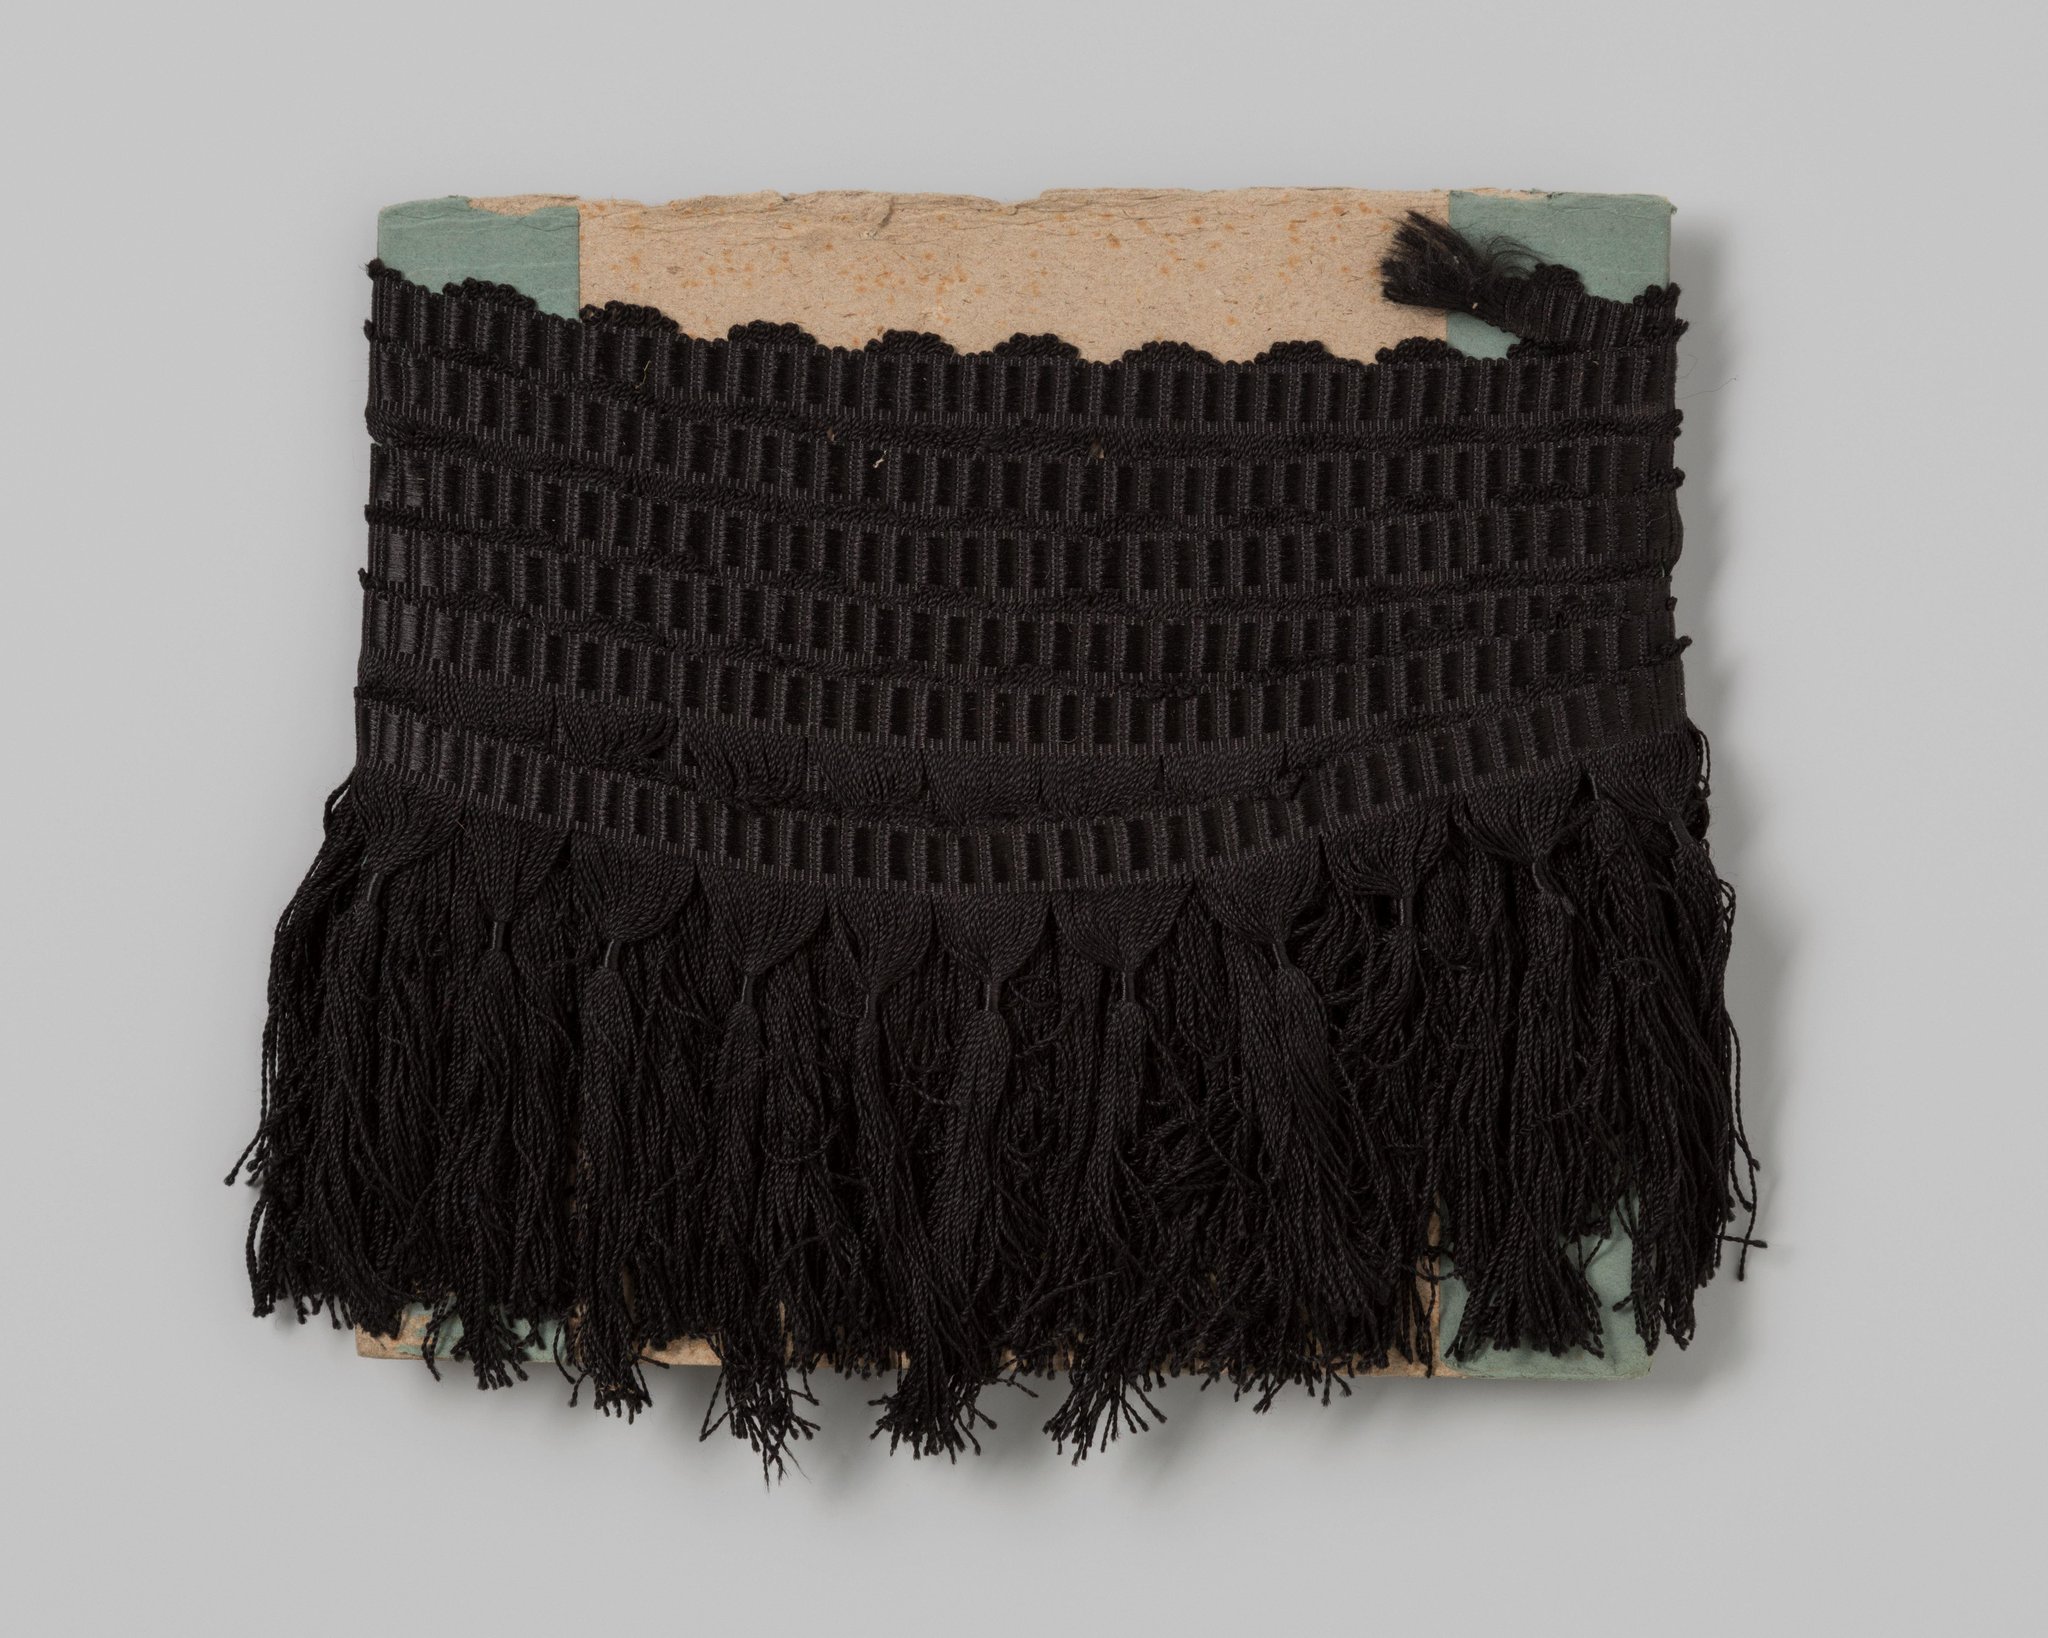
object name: ribbon material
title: Franje van zijde, zwart, op karton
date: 1920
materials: cardboard, silk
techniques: weave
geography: france